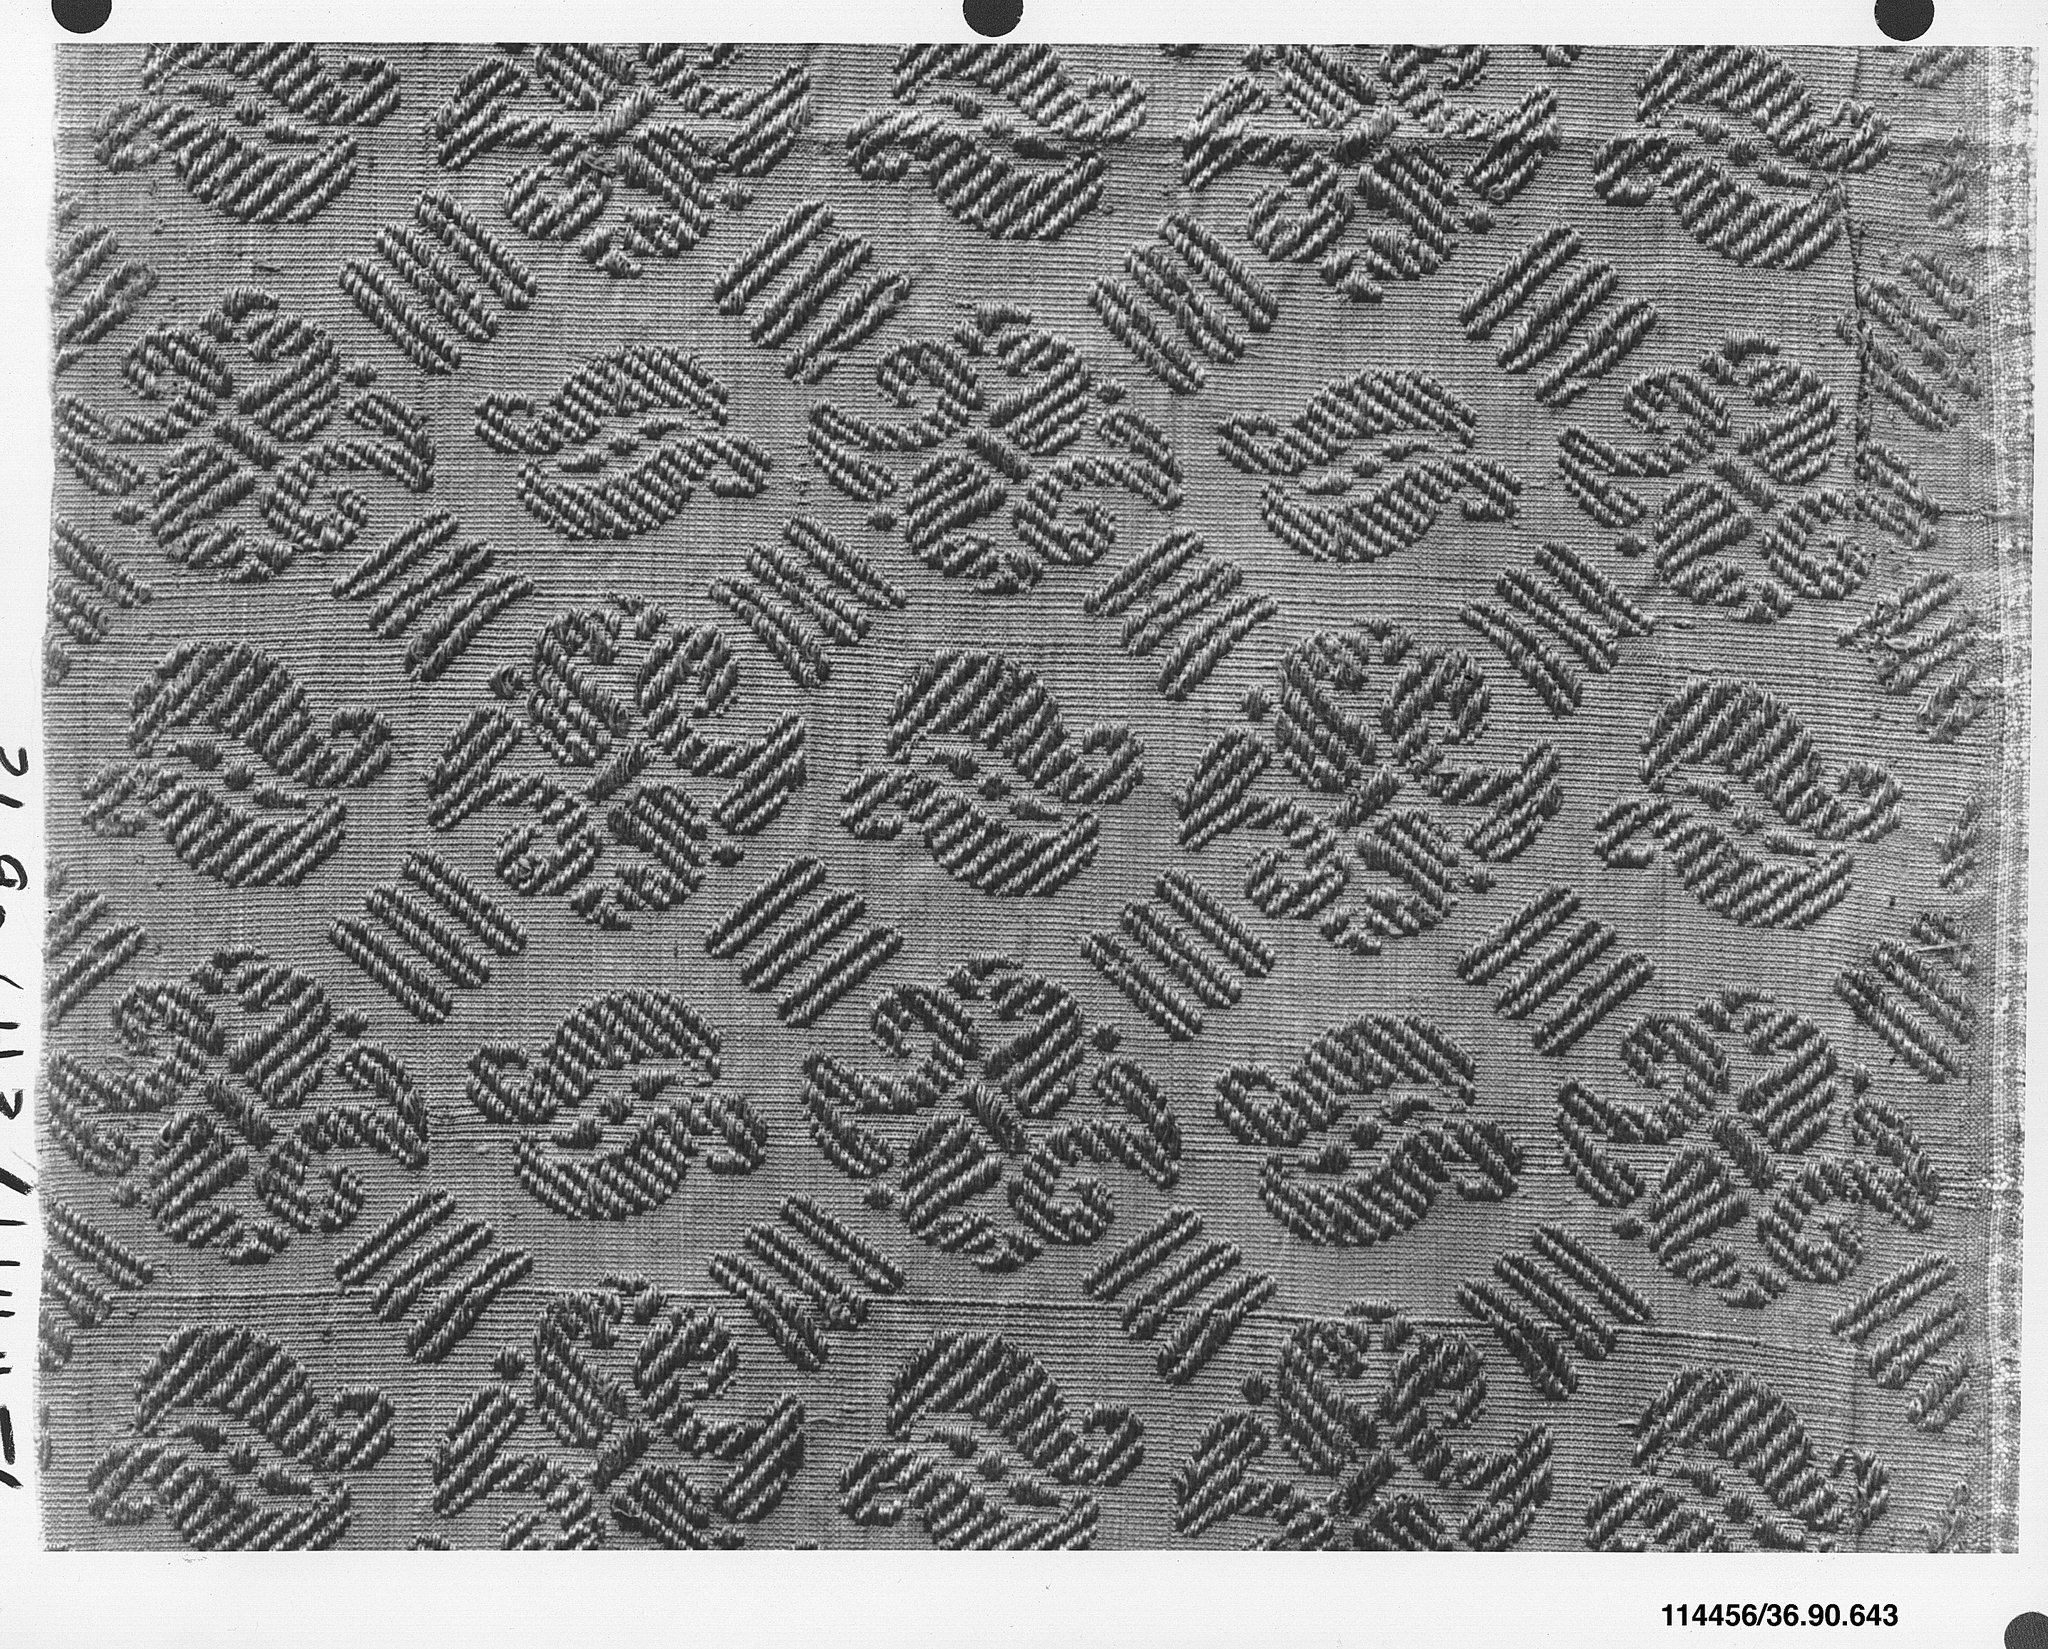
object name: piece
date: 1501-1700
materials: silk